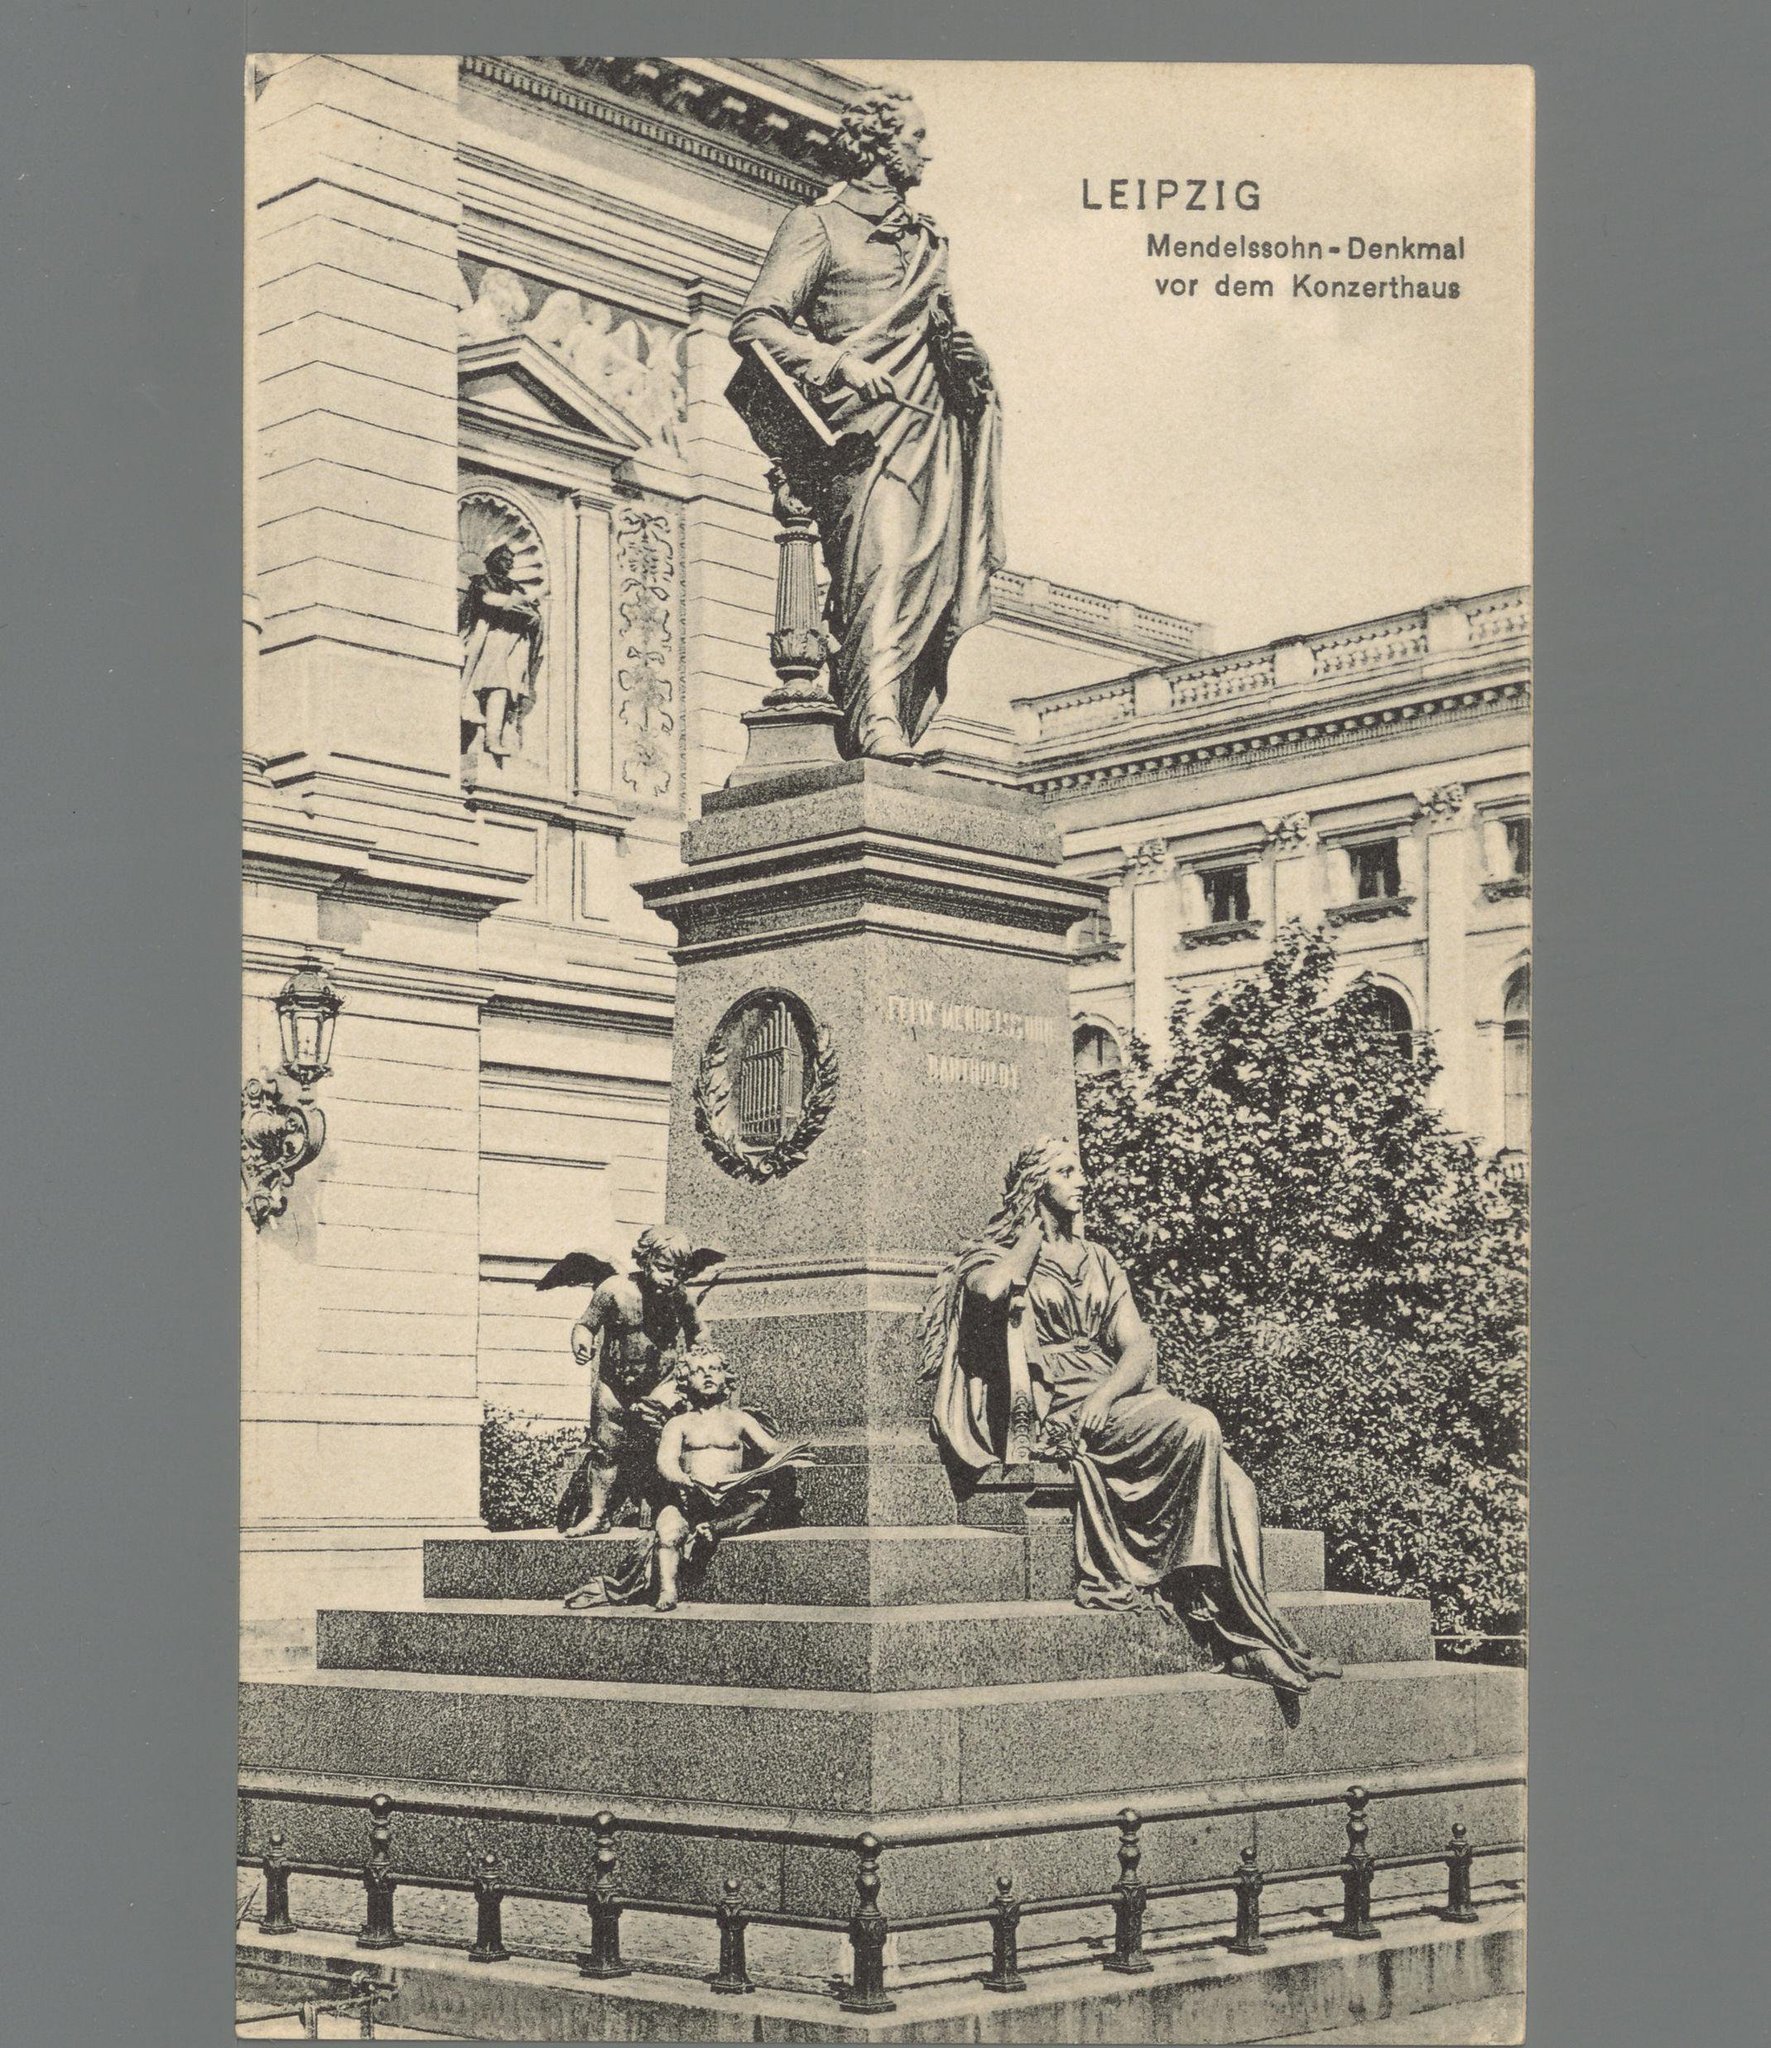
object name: photomechanical print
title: Leipzig. Mendelssohn-Denkmal vor dem Konzerthaus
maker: Anonymous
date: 1906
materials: cardboard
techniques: photograph, writing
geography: leipzig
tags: monument, statue, composer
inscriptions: date